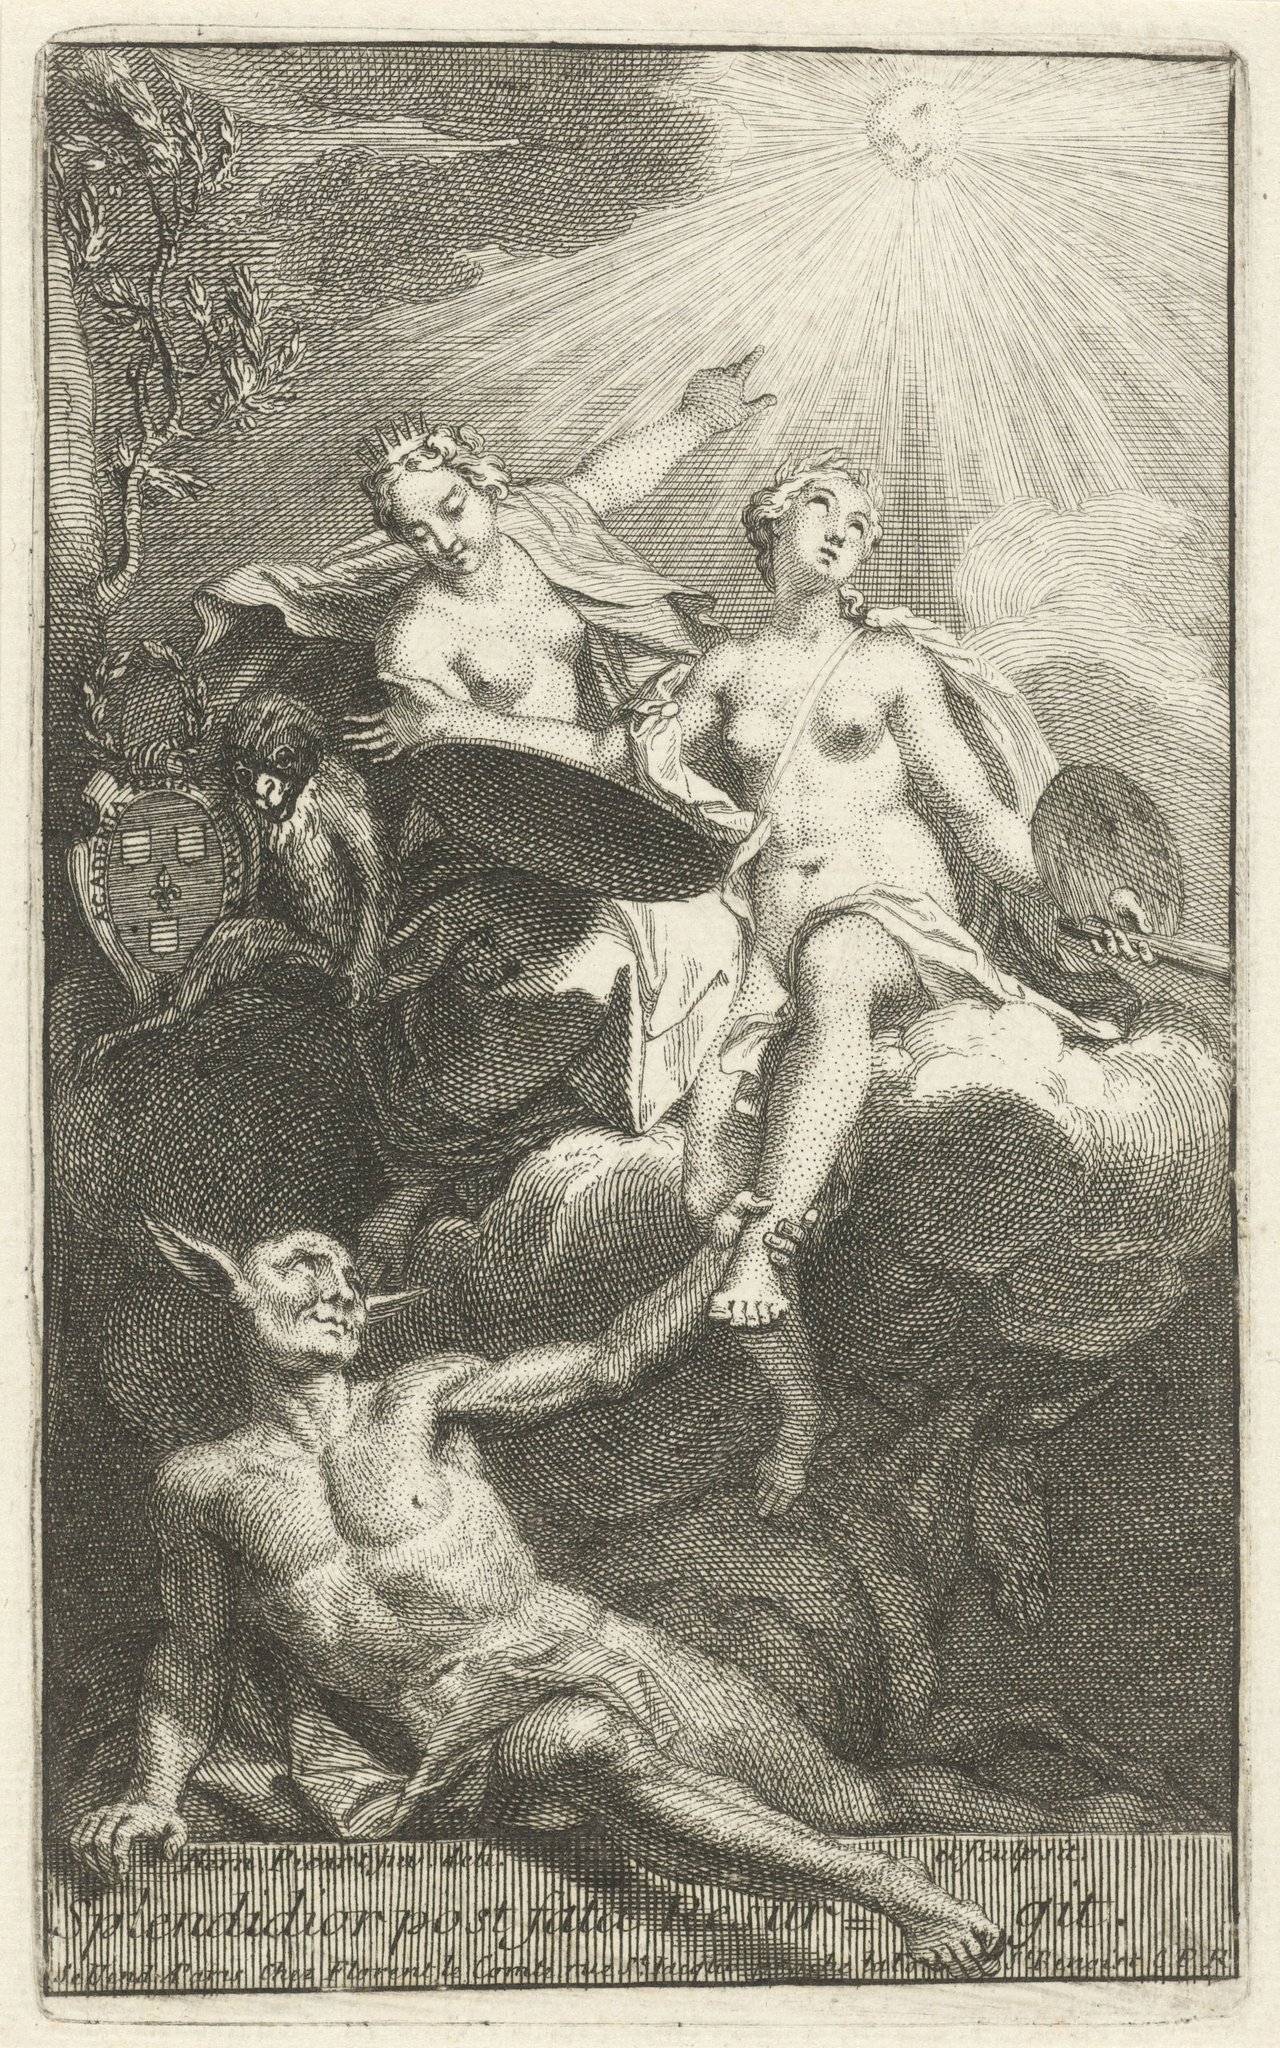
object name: titelblad, titelpagina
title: Titelpagina voor: F. Le Comte, Cabinet des singularitez d'architecture, peinture, sculpture, et graveure, 1699-1700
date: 1699-1700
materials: paper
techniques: engraving, etching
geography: paris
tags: 'pictura', symbolic representations, allegories and emblems ~ painting; 'pittura' (ripa), ass, donkey, monkeys, apes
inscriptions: collector's mark: Lugt 2228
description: Titelpagina voor: Le Comte, Florent. Cabinet des singularités d'architecture, peinture, sculpture, et gravure ou introduction à la connaissance des plus beaux arts, figurés sous les tableaux, les statues et les estampes, deel III. Parijs: Nicolas Le Clerc en Estienne Pigart, 1699-1700.